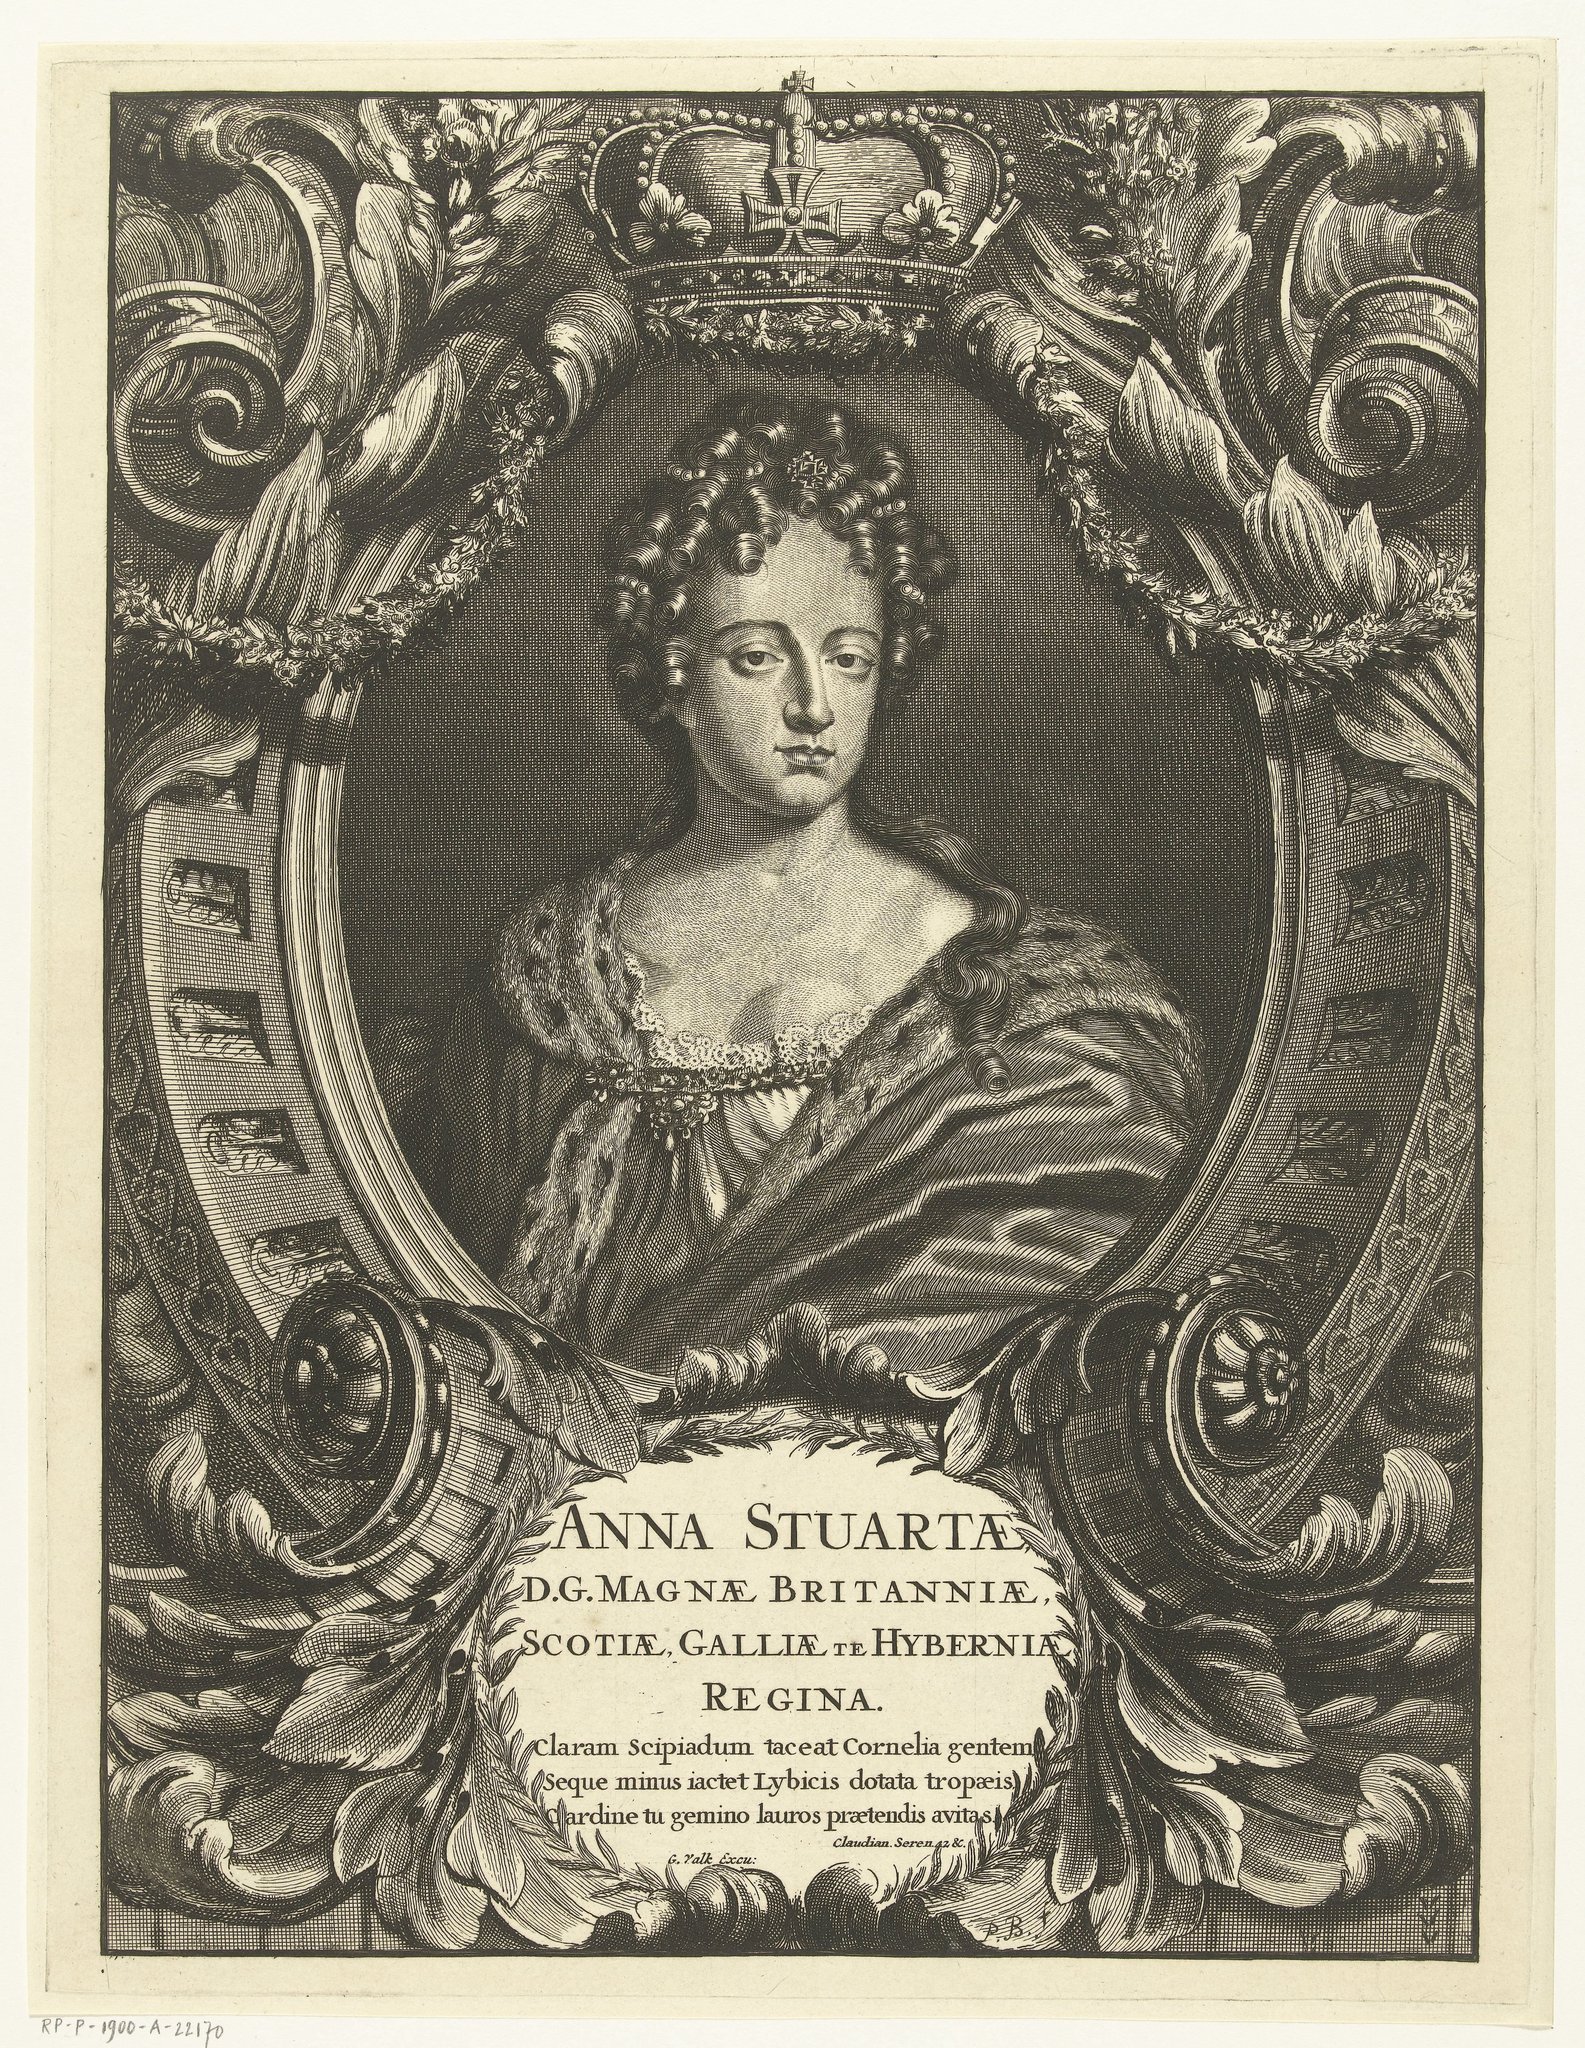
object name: print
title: Portret van Anna, Koningin van Engeland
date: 1702-1731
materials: paper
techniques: engraving, etching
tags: london, anna stuart (koningin van engeland en schotland), crown (symbol of sovereignty), historical persons - bb - woman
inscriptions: signature: ‘P.B. f.’, collector's mark: Lugt 2228, title: ‘ANNA STUARTAE.....REGINA...avitas’, address: ‘G. Valck Excu.’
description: Portret in ovale lijst van Anna, koningin van Engeland, Schotland en Ierland. Buste naar rechts. Ze draagt een hermelijnen mantel. De ornamentale ovale omlijsting heeft middenboven de koninklijke kroon. Middenonder titel en latijns onderschrift in cartouche.